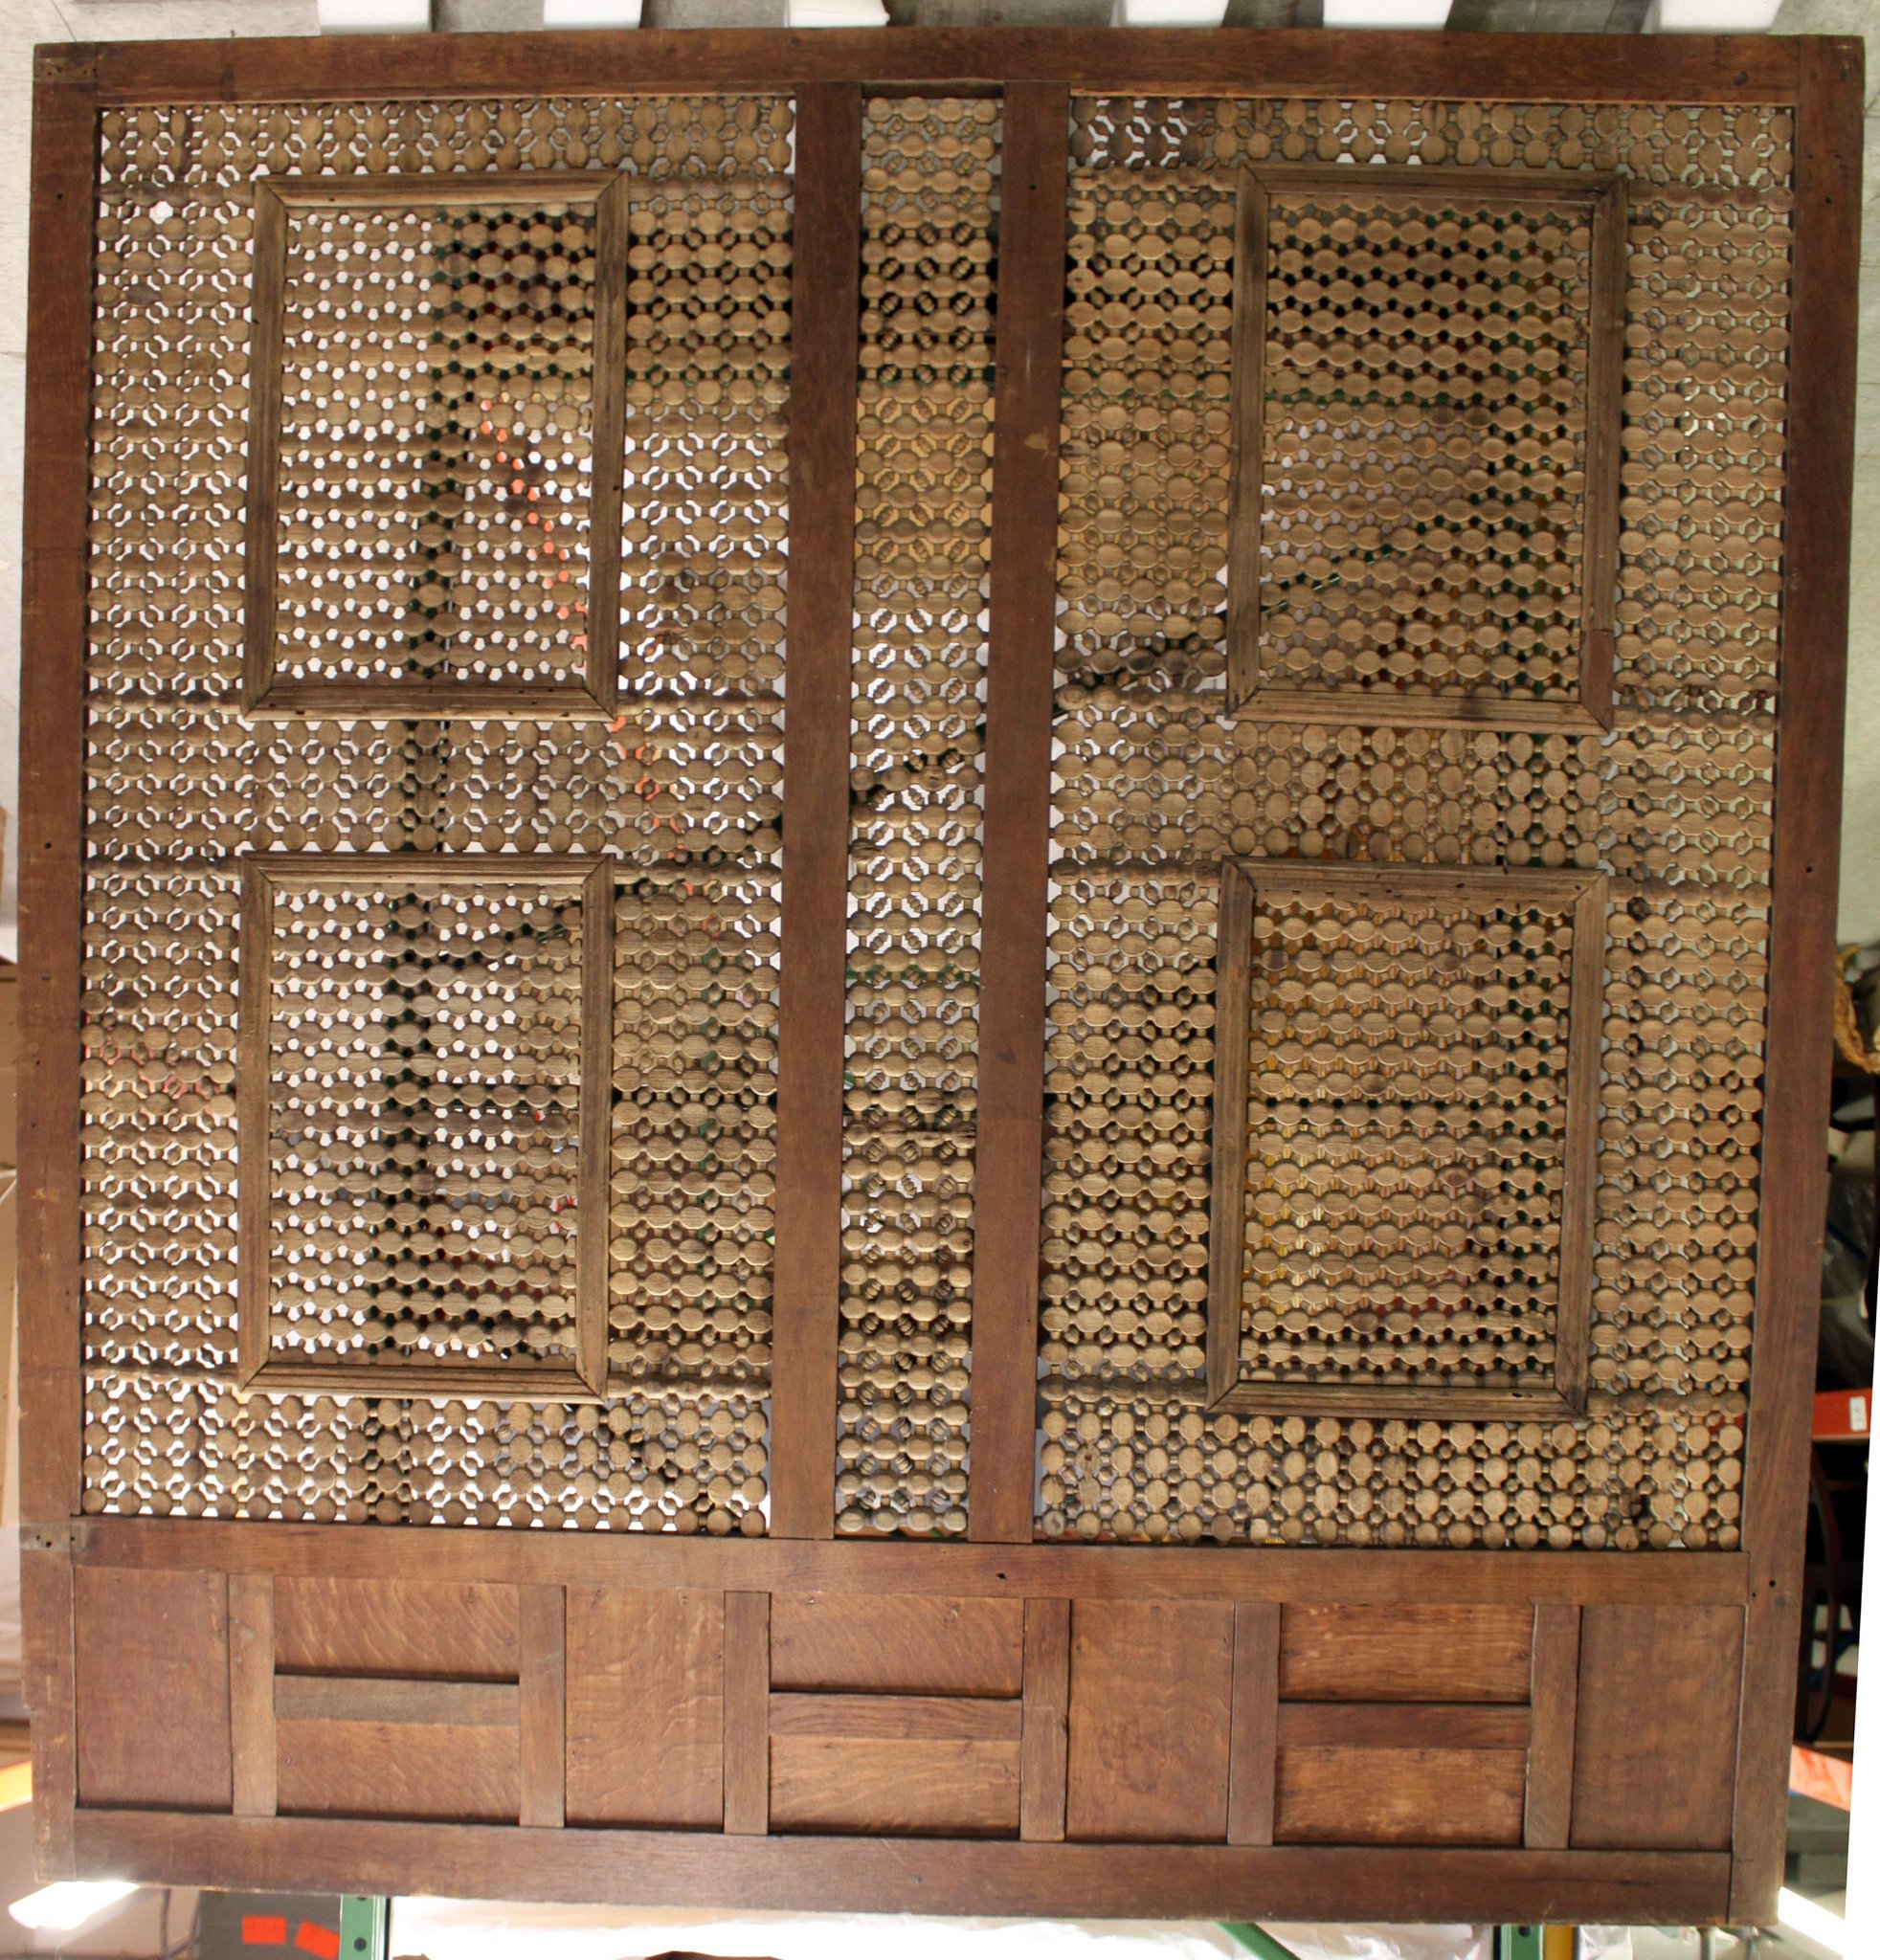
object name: screen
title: Mashrabiyya Screen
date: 1401-1600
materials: wood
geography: egypt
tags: screens